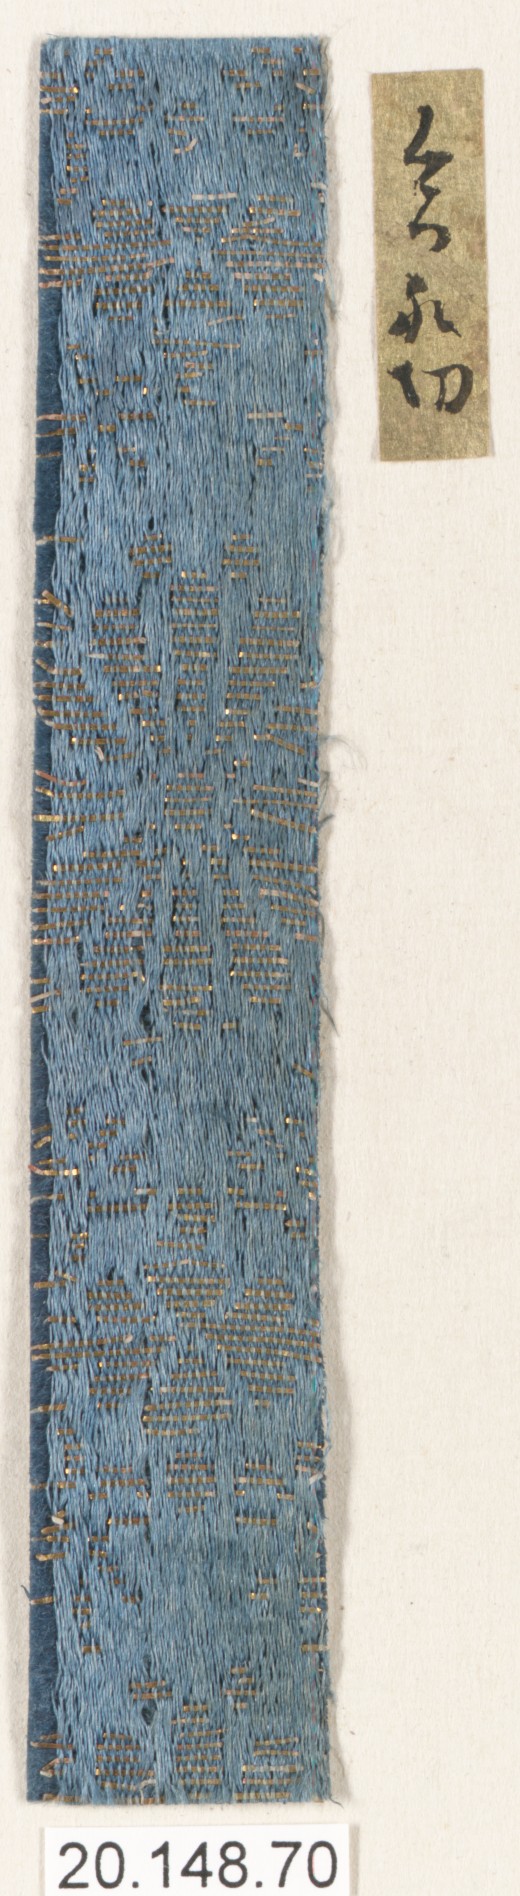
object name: piece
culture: japanese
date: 1501-1600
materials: silk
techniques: compound weave